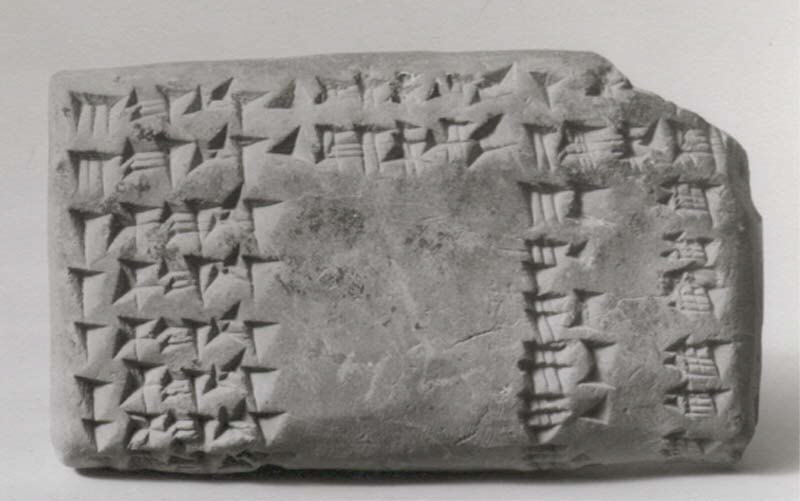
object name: cuneiform tablet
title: Cuneiform tablet: account of gold, Ebabbar archive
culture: babylonian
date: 700-501 BCE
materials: clay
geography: mesopotamia